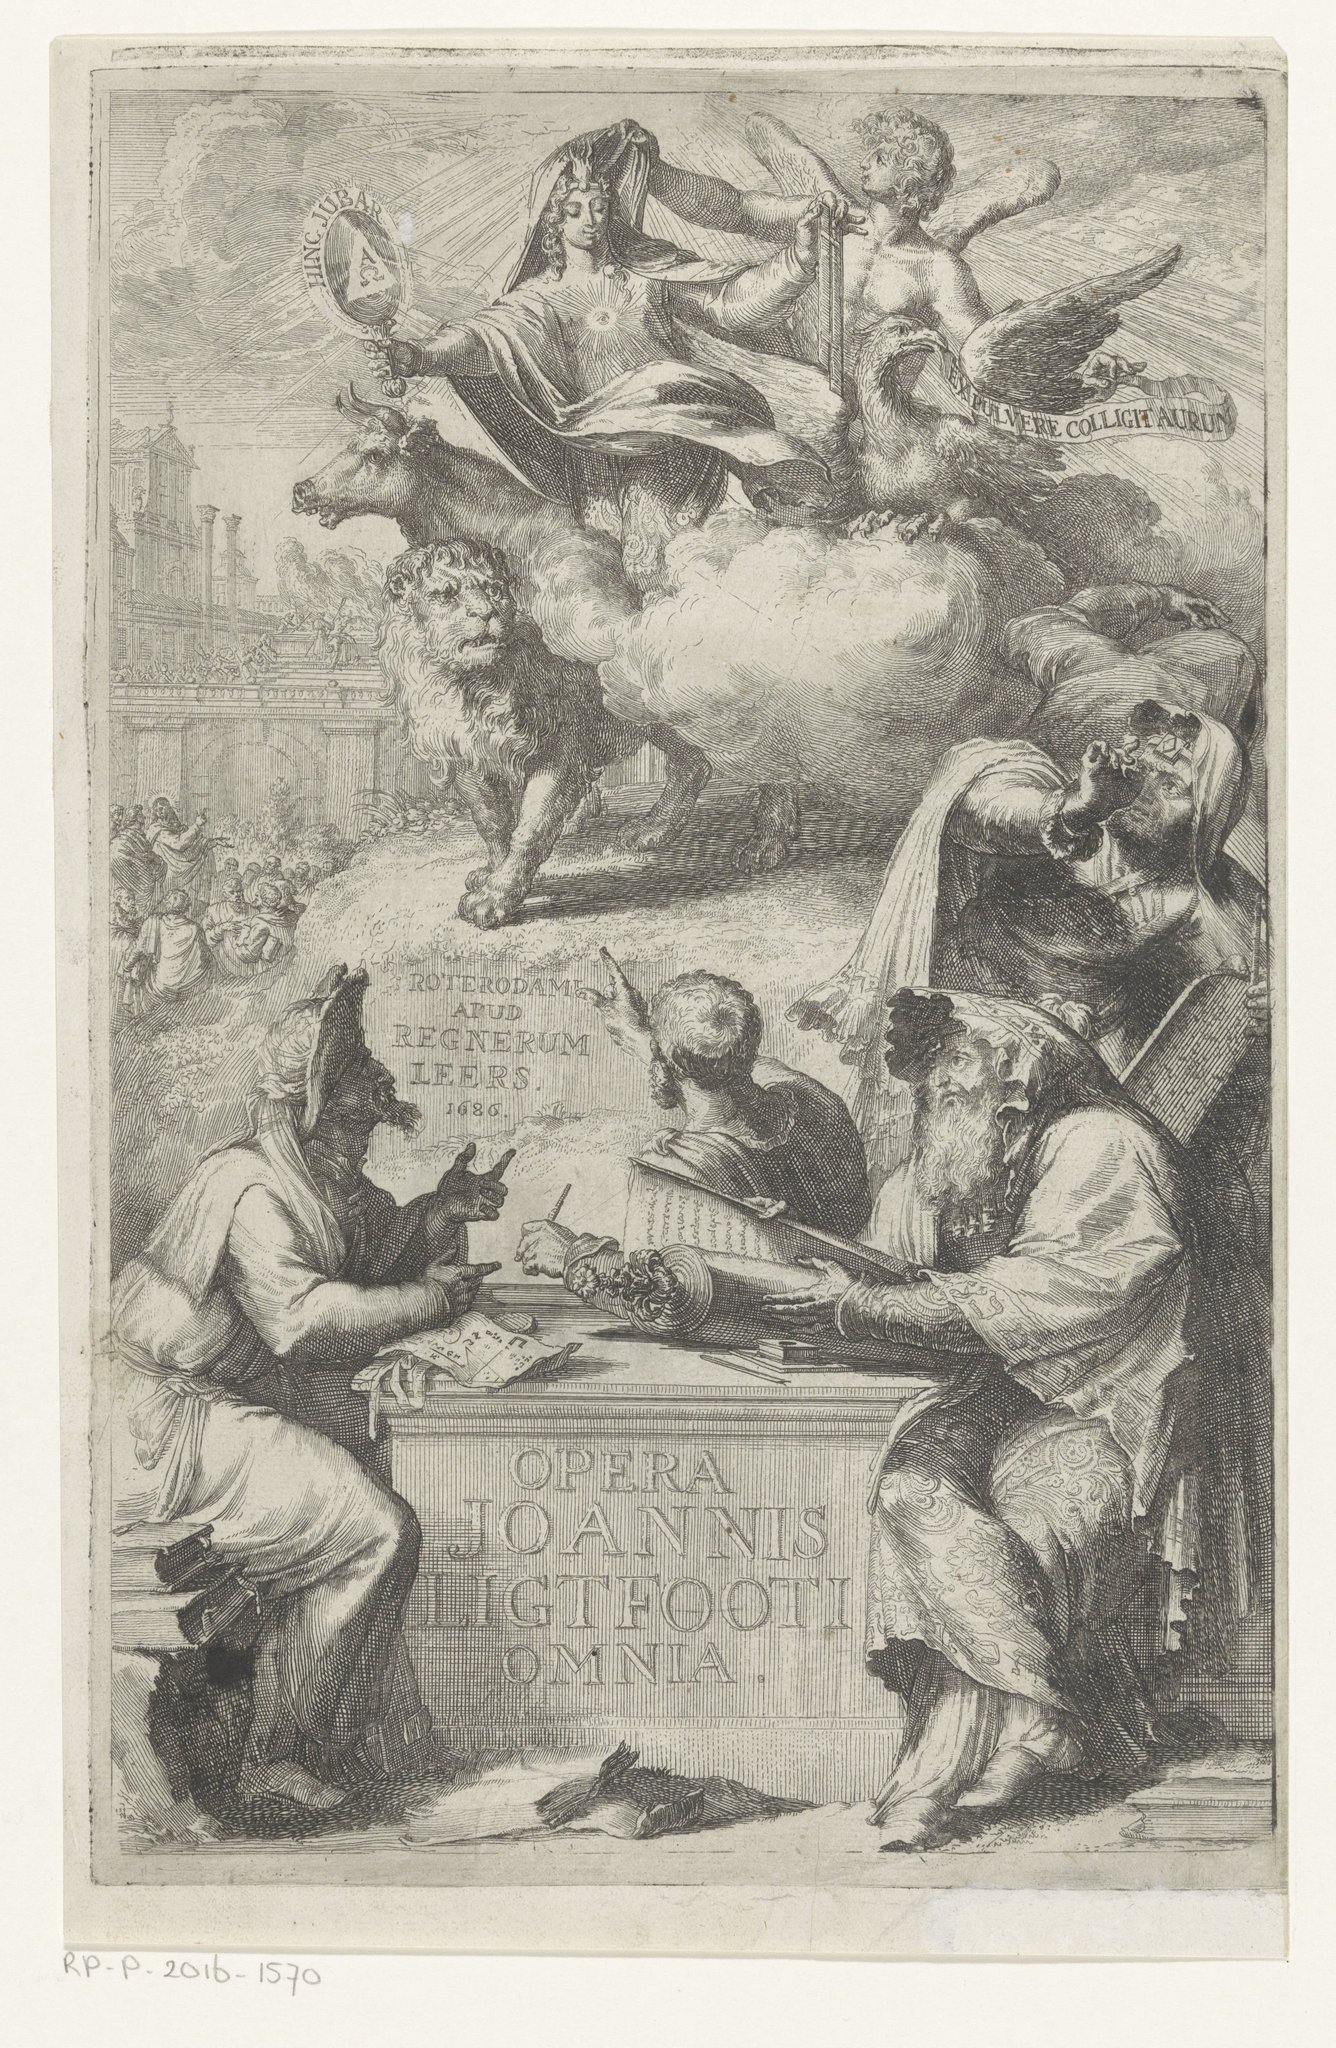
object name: titelblad, titelpagina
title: Allegorische figuur met Joodse man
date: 1686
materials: paper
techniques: engraving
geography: rotterdam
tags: truth; 'verità' (ripa), studying the torah, the talmud, etc. ~ personal duties in jewish life, jewish religion and culture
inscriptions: collector's mark: Lugt 2228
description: Bij een voetstuk of stenen tafel zit een joodse man, omringd door drie mannen, met een boekrol waarop Hebreeuwse teksten staan. Op de achtergrond een allegorische figuur (mogelijk Waarheid) omringd door de vier evangelistensymbolen.